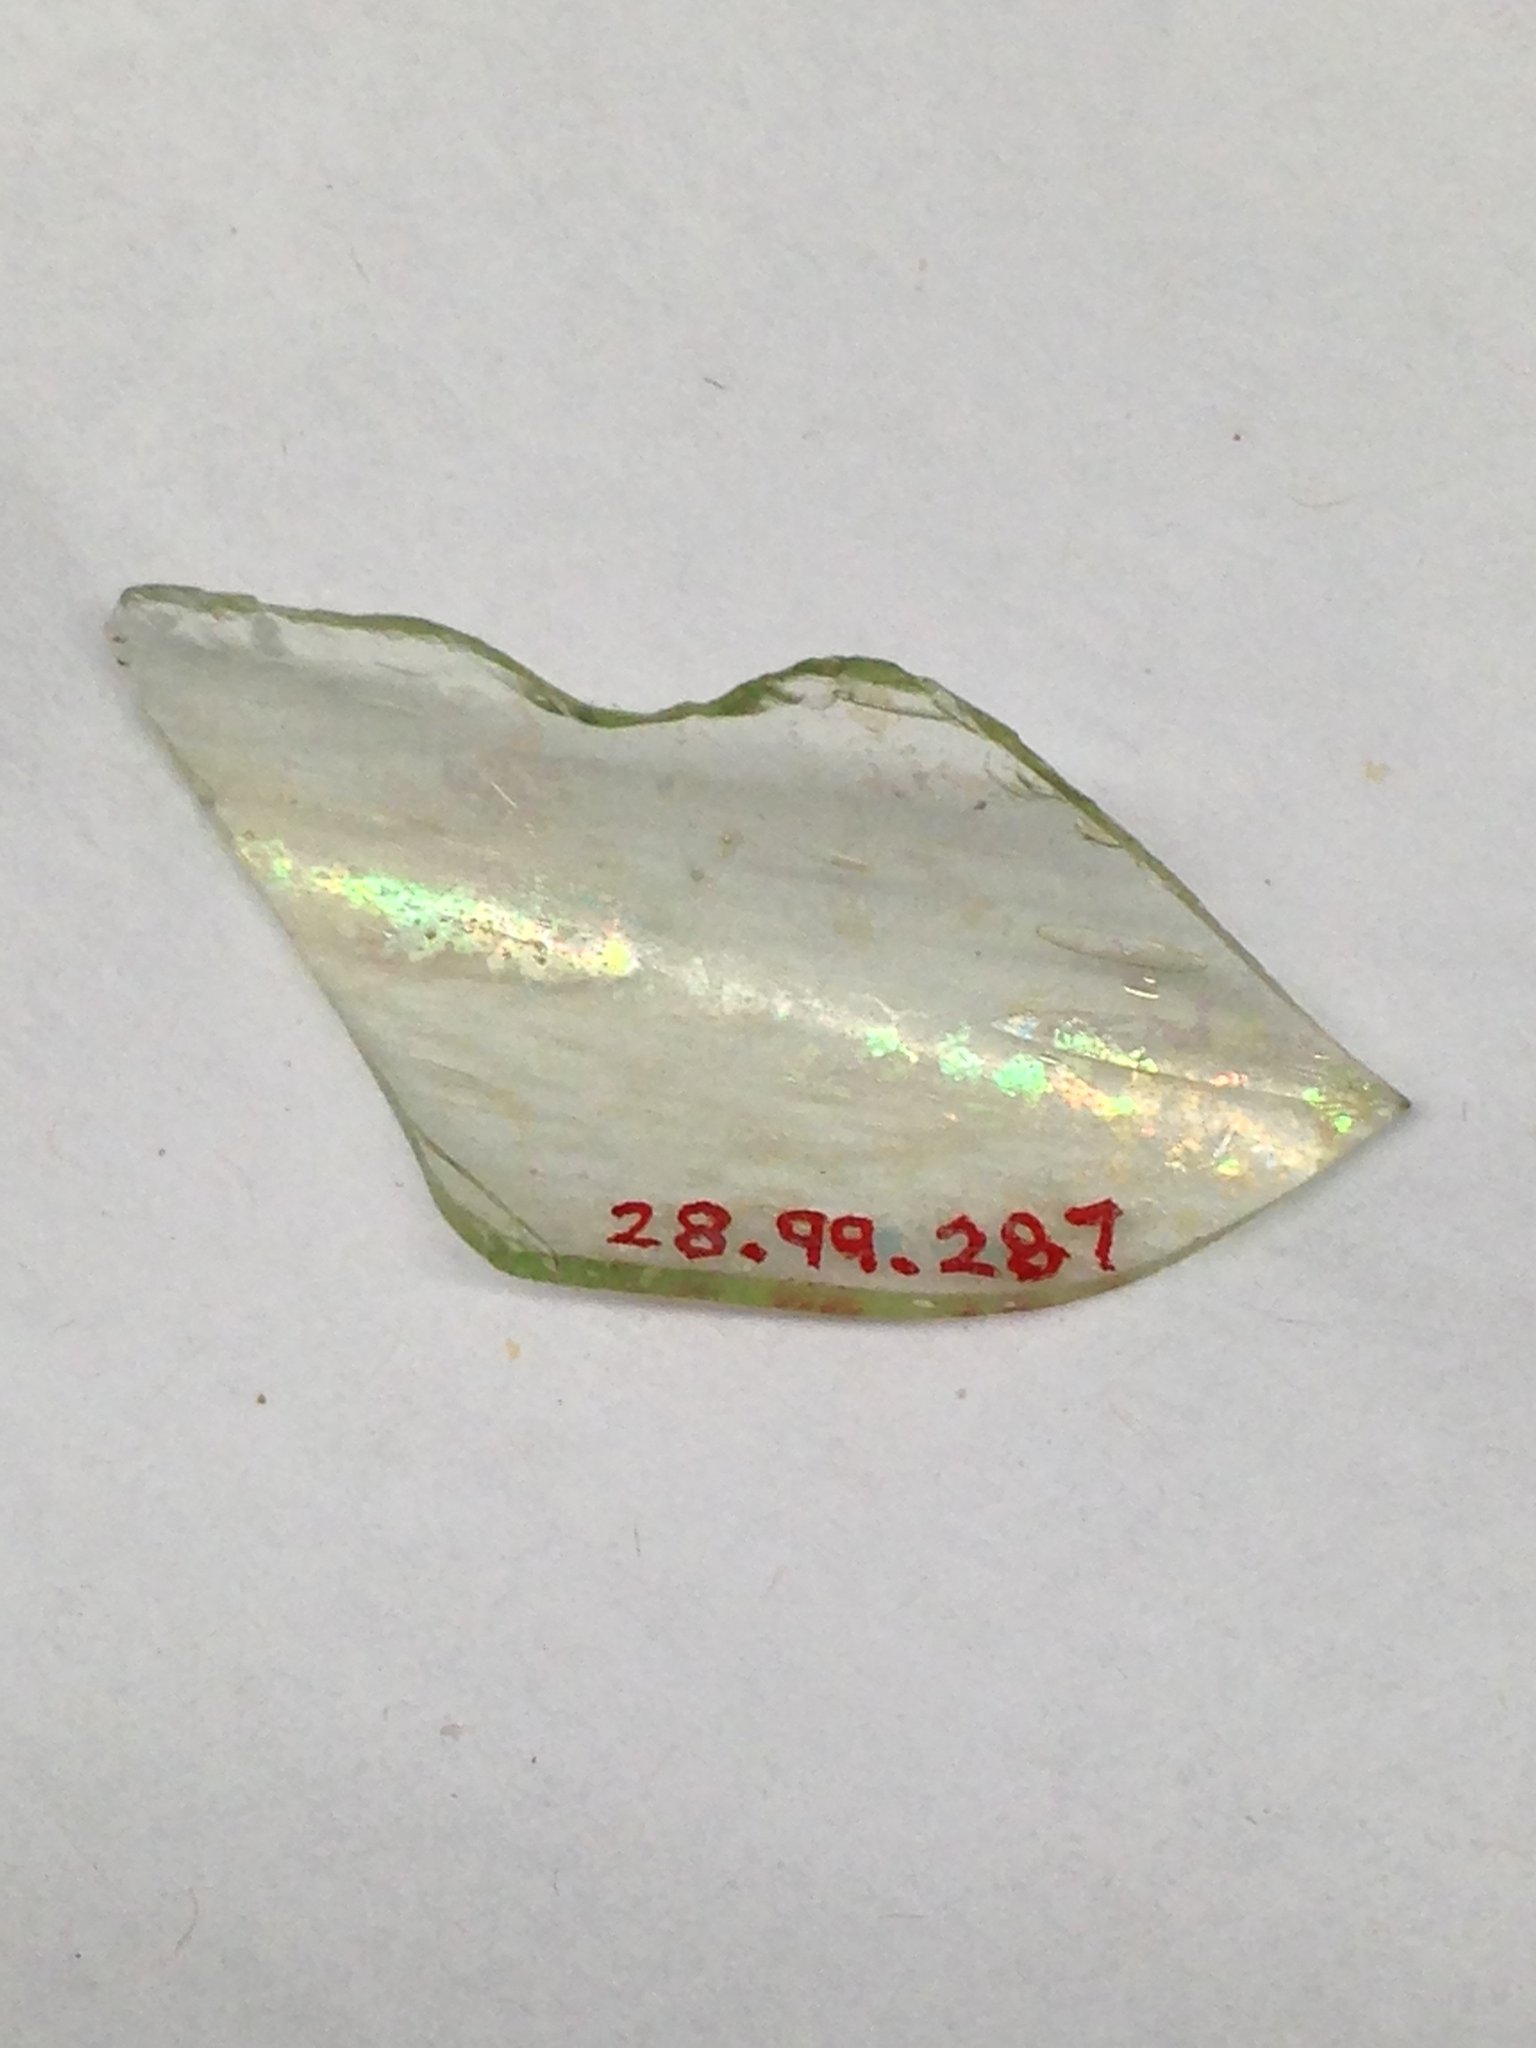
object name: fragment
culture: european or middle eastern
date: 1150-1250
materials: ceramic, glass